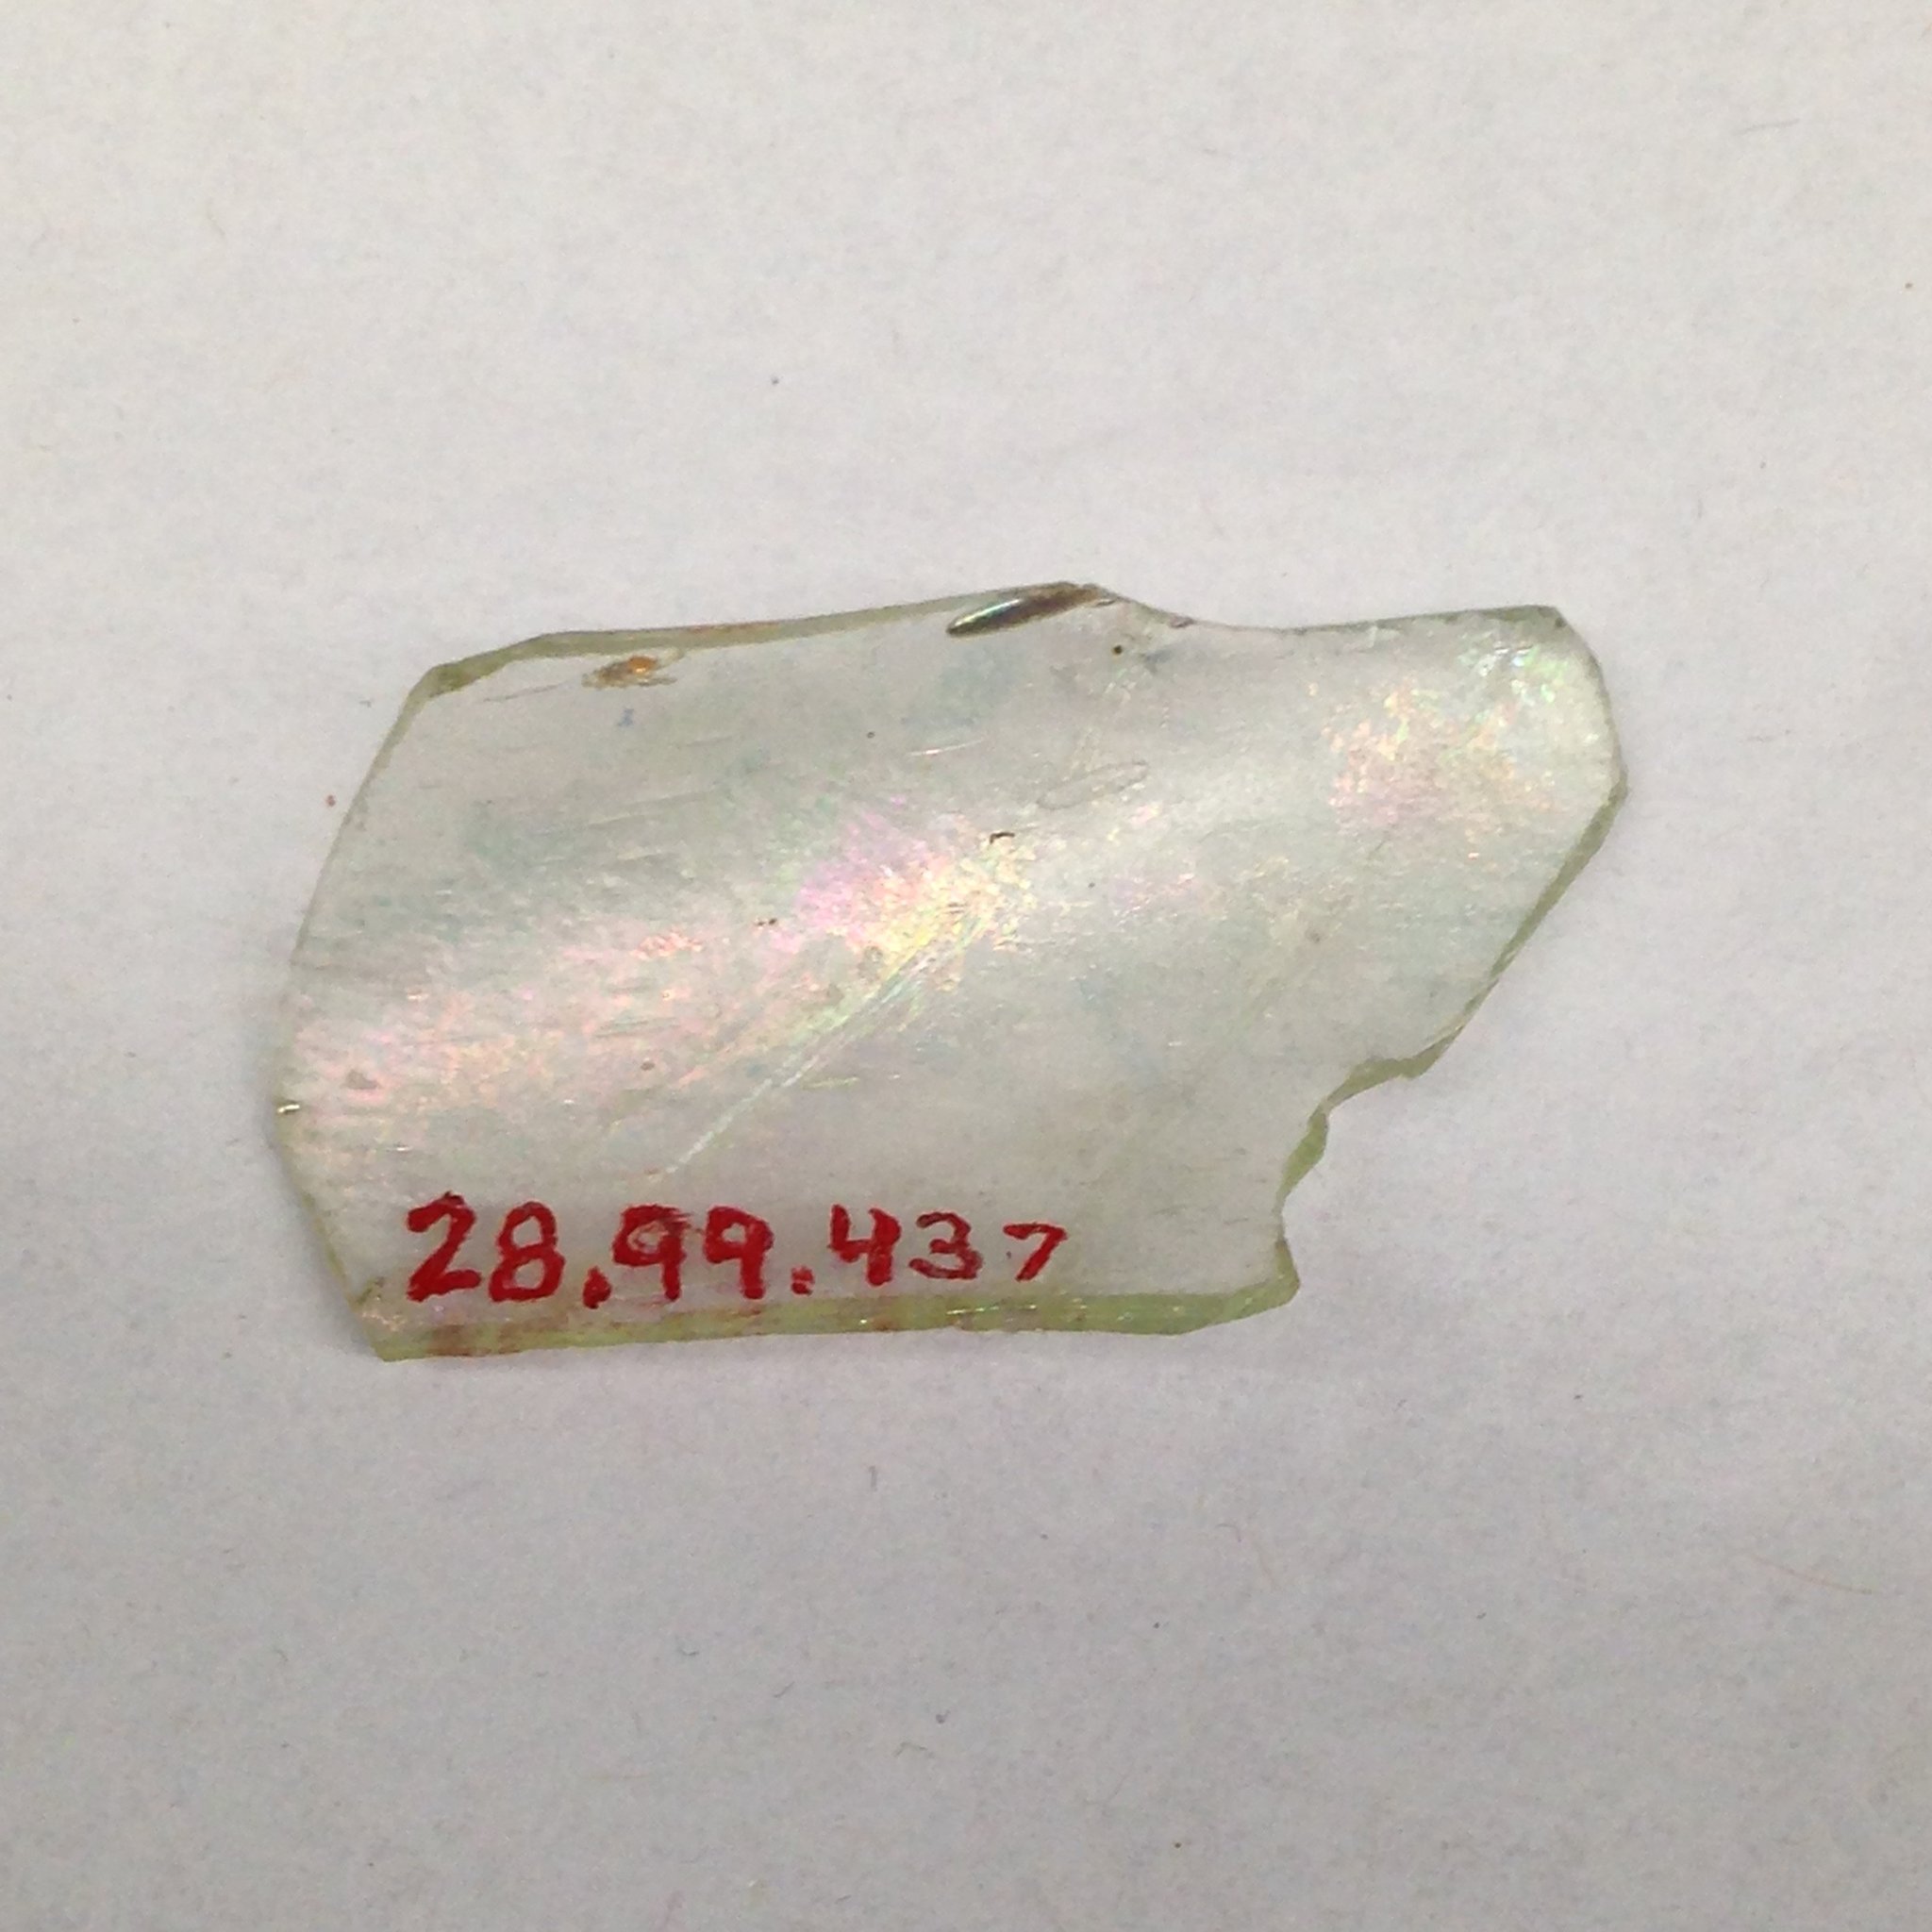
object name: fragment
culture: european or middle eastern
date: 1150-1250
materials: ceramic, glass